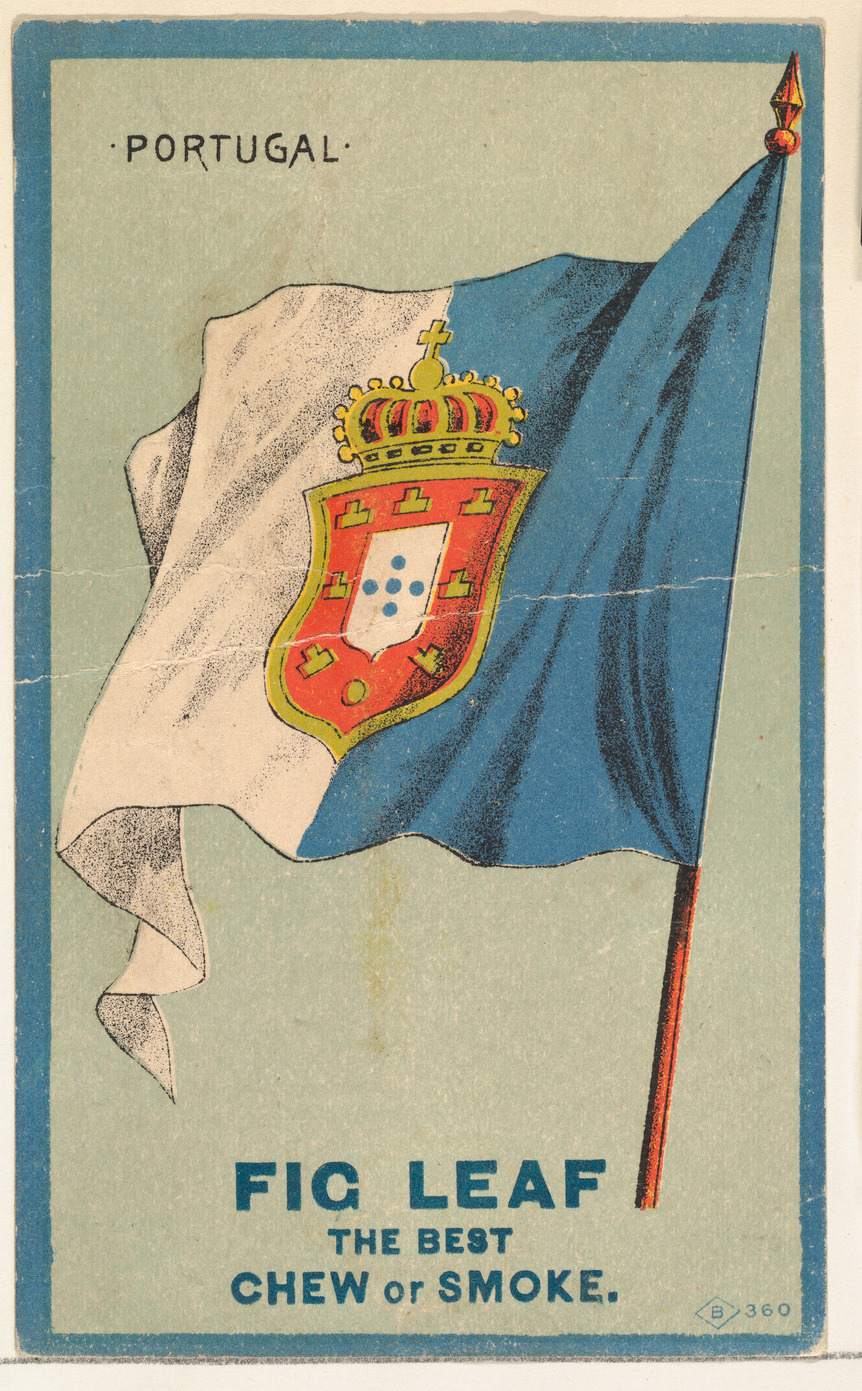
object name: print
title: Portugal, from the National Flags series (N195) issued by Wm. S. Kimball & Co.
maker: william s. kimball & company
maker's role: publisher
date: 1891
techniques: color lithograph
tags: coat of arms,flags